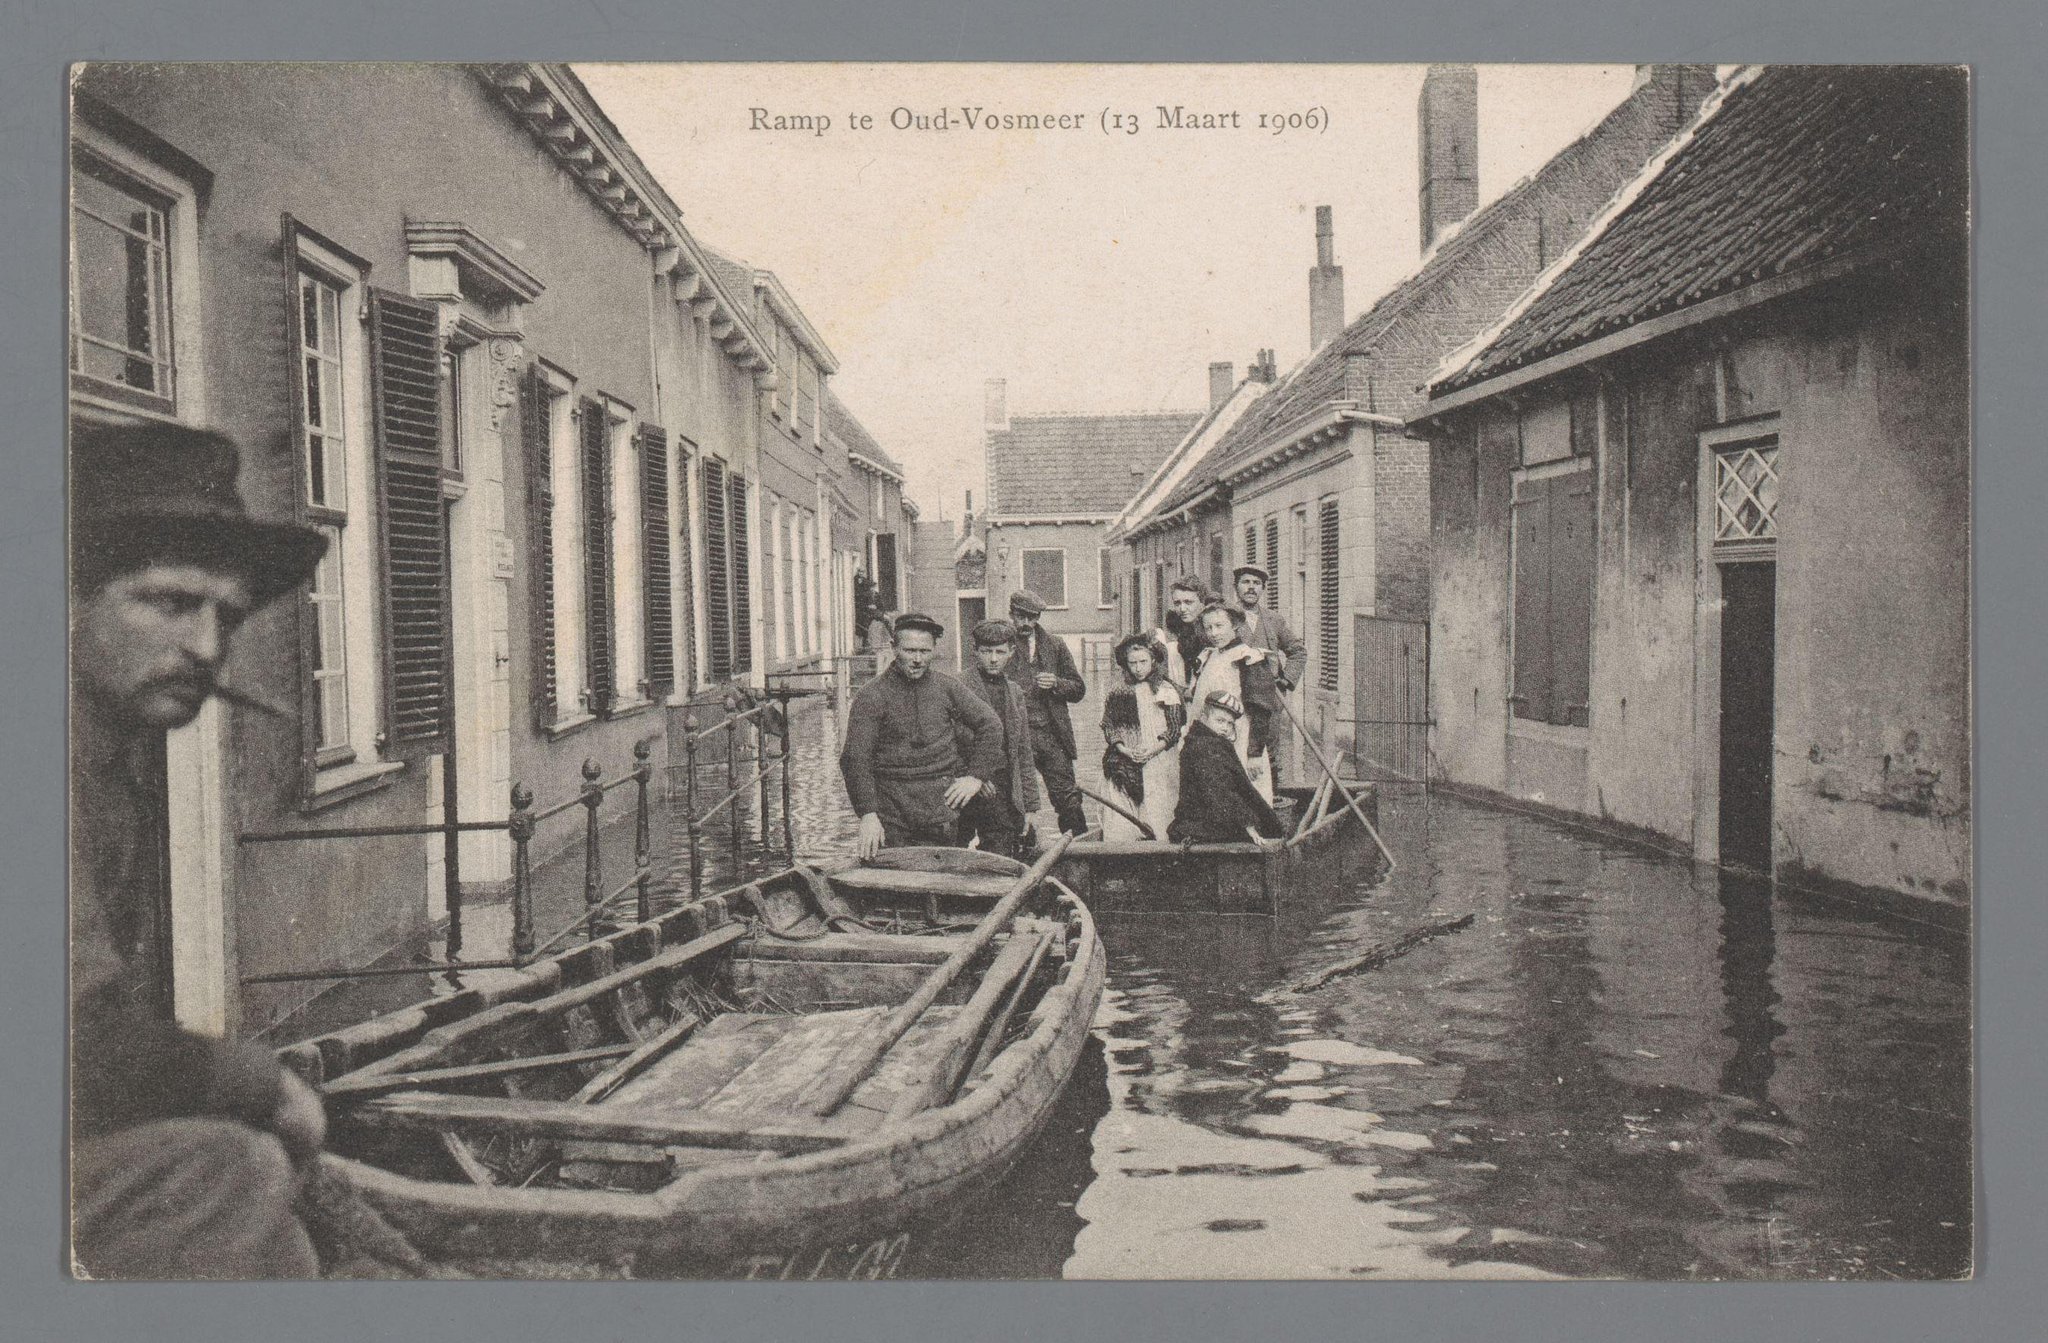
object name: ansichtkaart, prentbriefkaart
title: Ramp te Oud-Vossemeer op 13 maart 1906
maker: p.j. daniëlse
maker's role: publisher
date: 1906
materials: paper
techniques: printing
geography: middelburg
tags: zeeland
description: Briefkaart, zwart-wit. Ramp Oud-Vossemeer, 13 maart 1906.